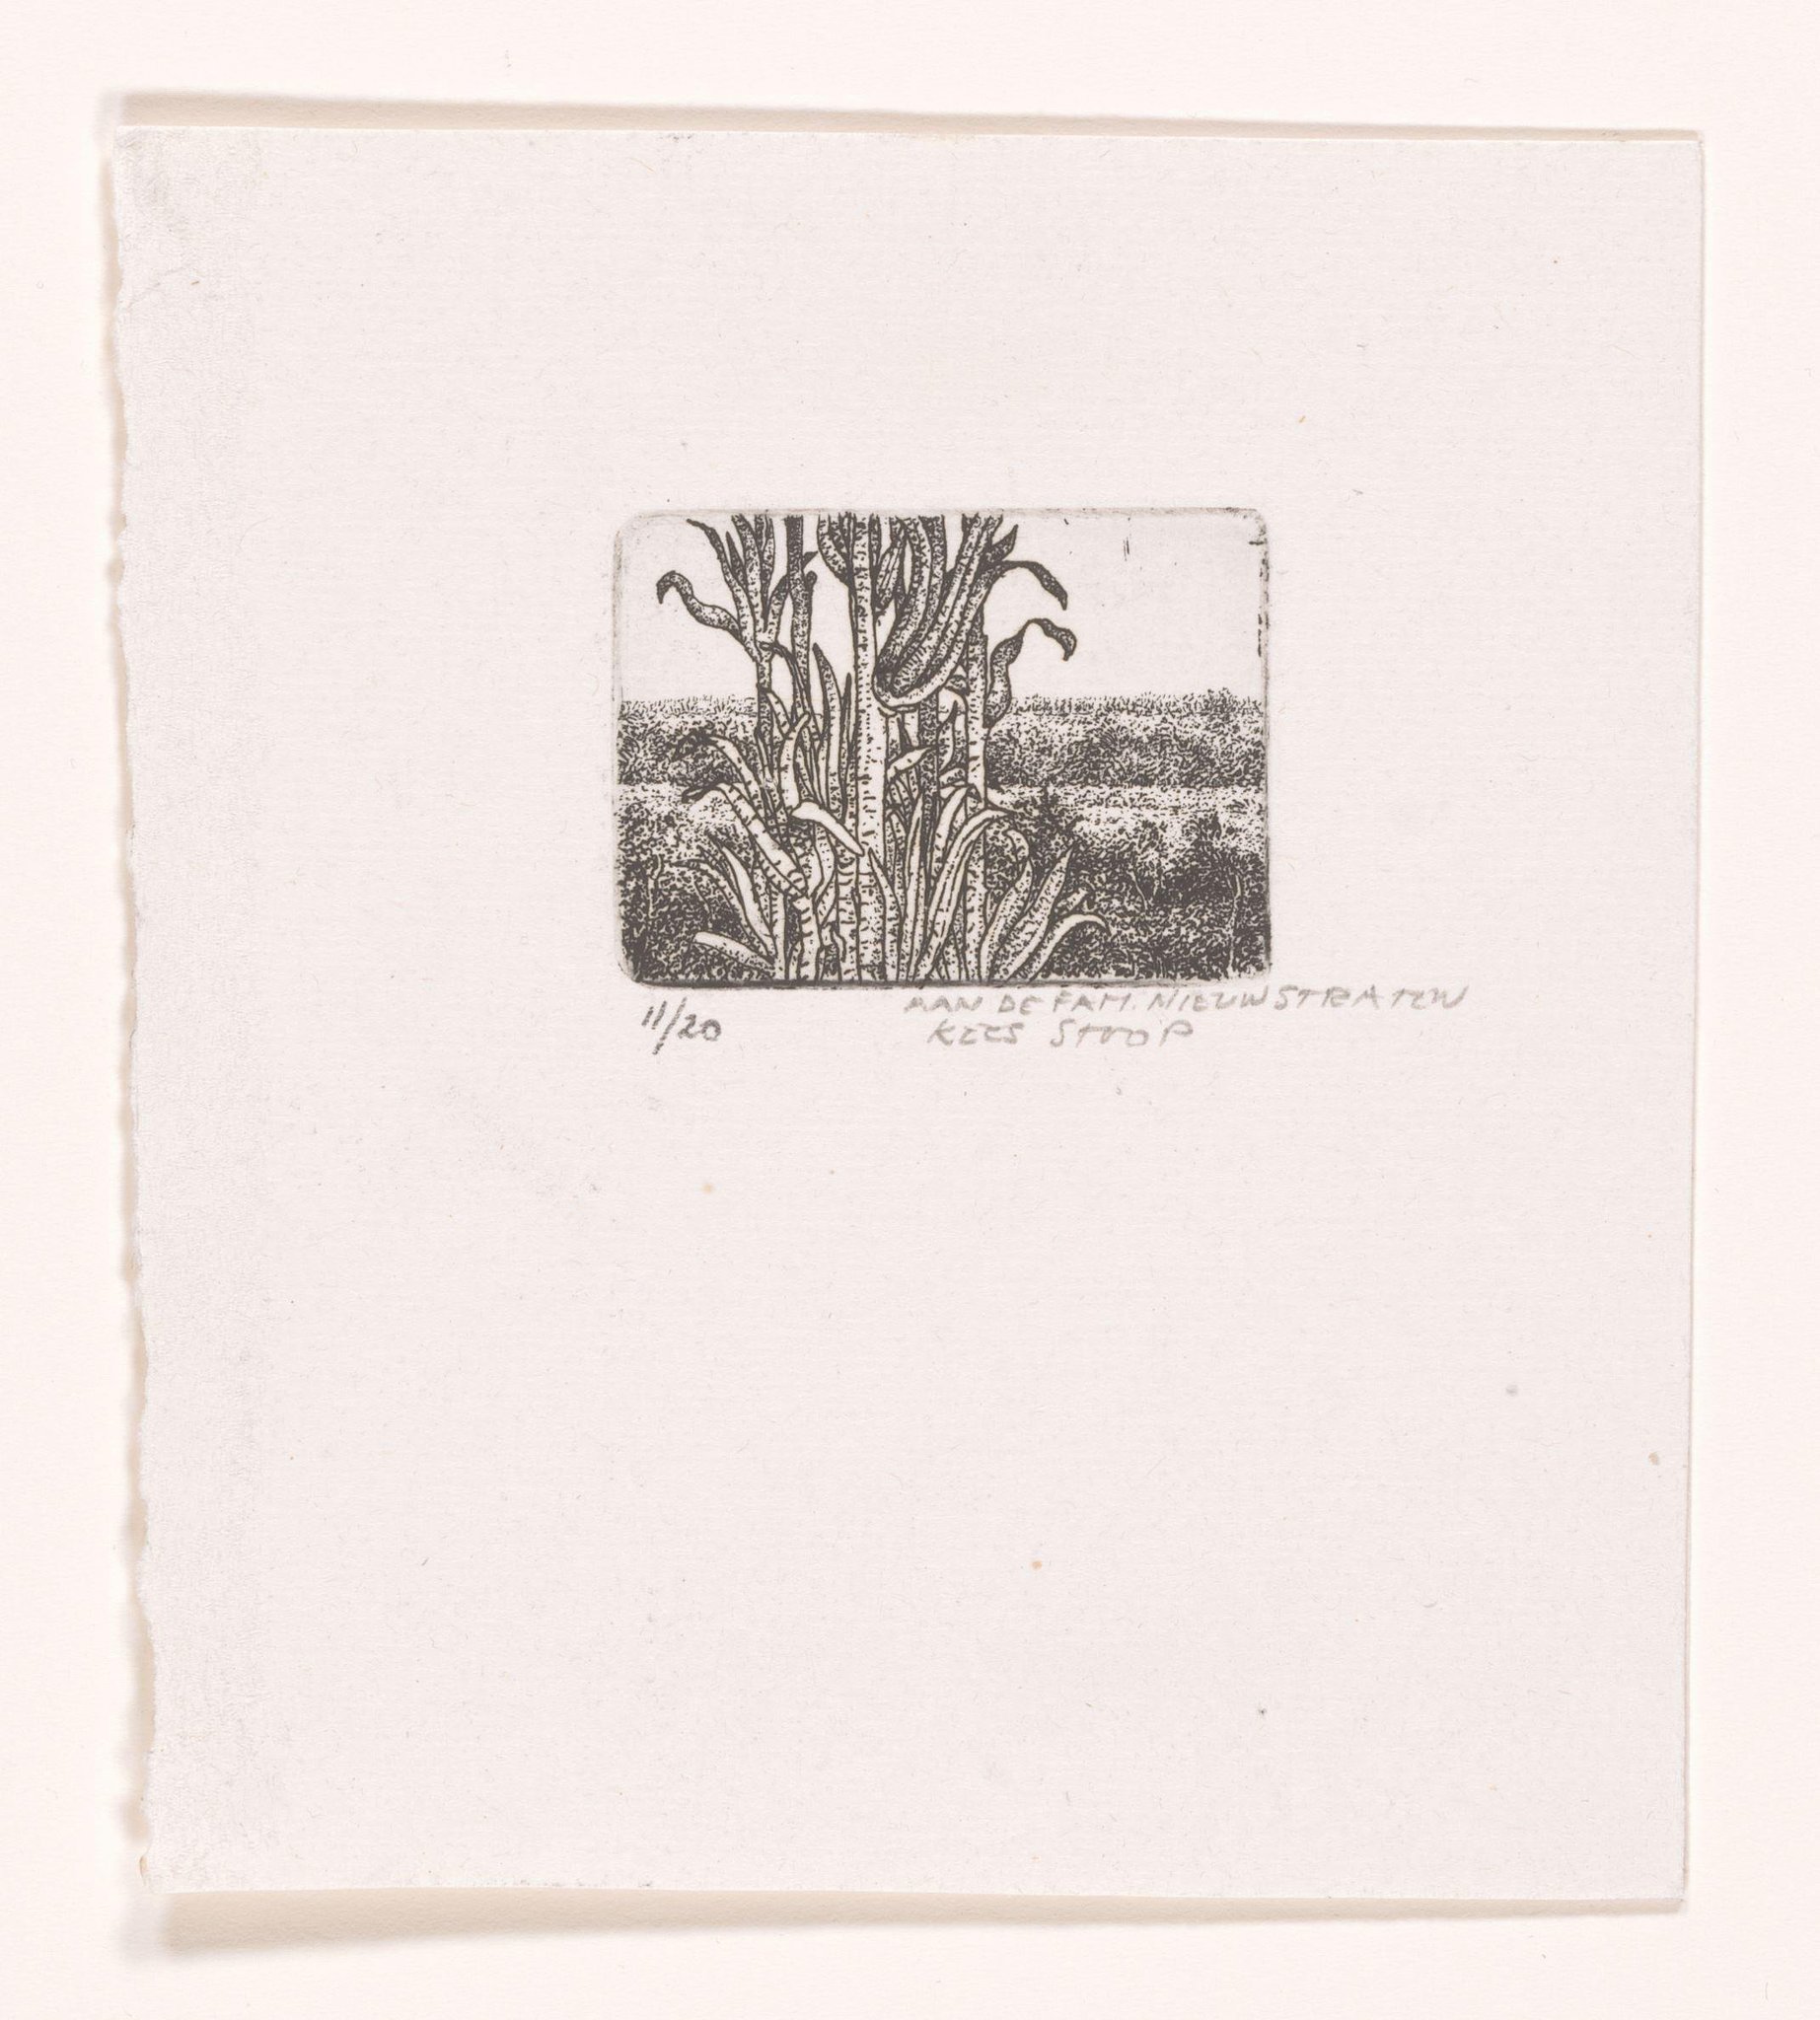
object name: print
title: Stengels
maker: kees stoop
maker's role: draughtsman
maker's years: 1929-2019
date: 1944-1990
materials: paper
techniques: etching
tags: plants and herbs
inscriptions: signature: ‘KEES STOOP’, inscription: ‘AAN DE FAM. NIEUWSTRATEN’, edition: ‘11/20’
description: Stengels op de voorgrond, op de achtergrond een vergezicht van een landschap.